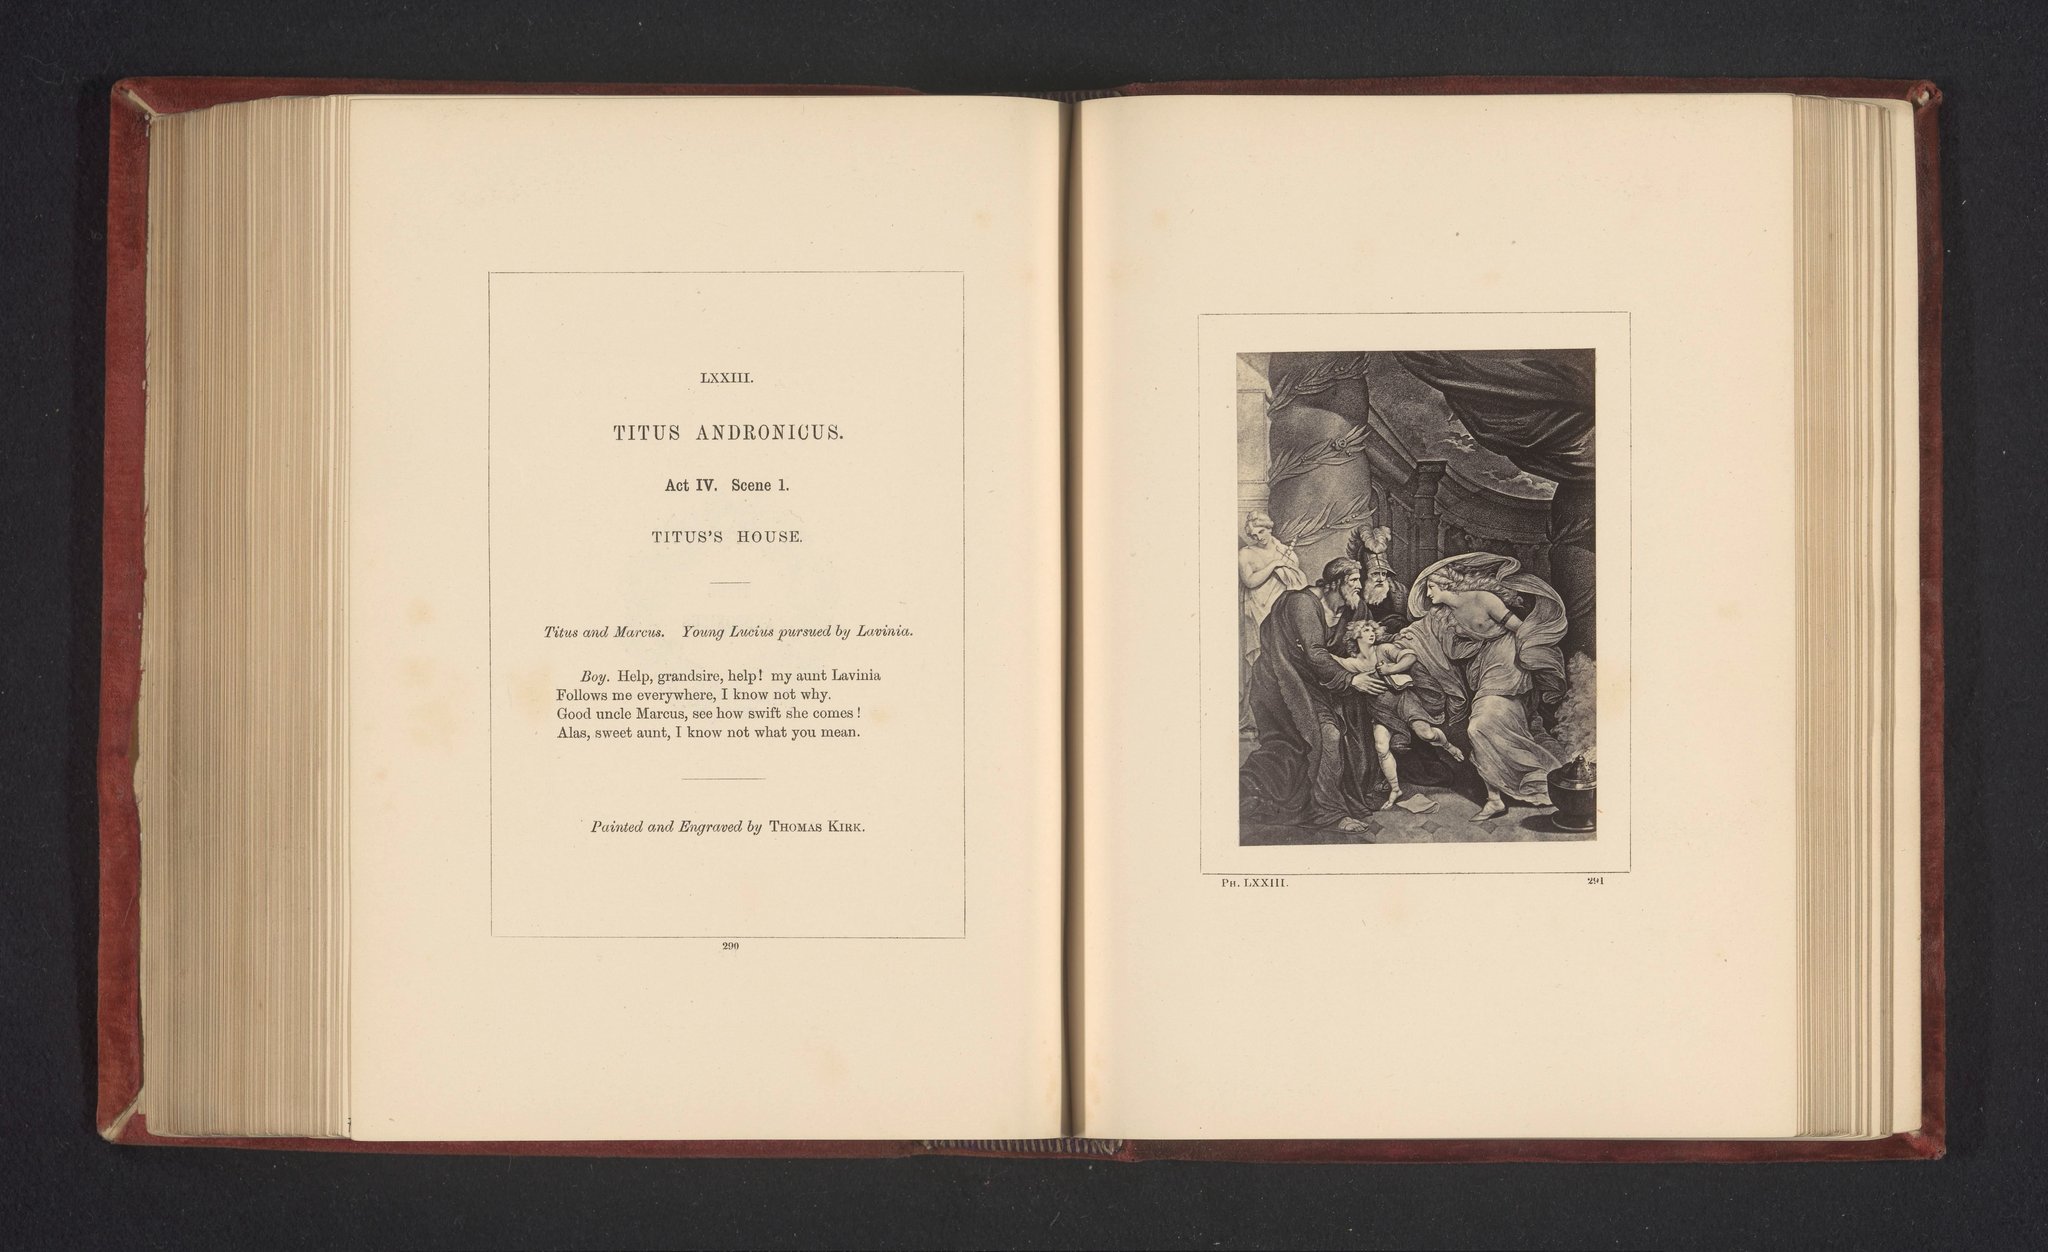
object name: photograph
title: Fotoreproductie van een prent naar een schilderij door Thomas Kirk, voorstellend een scene uit Titus Andronicus door William Shakespeare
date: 1854-1864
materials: photographic support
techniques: albumen print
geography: london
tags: specific works of literature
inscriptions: number: ‘Ph. LXXIII. 291’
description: Te zien is akte IV, scene 1 met Lucius die wordt achtervolgd door Lavinia.